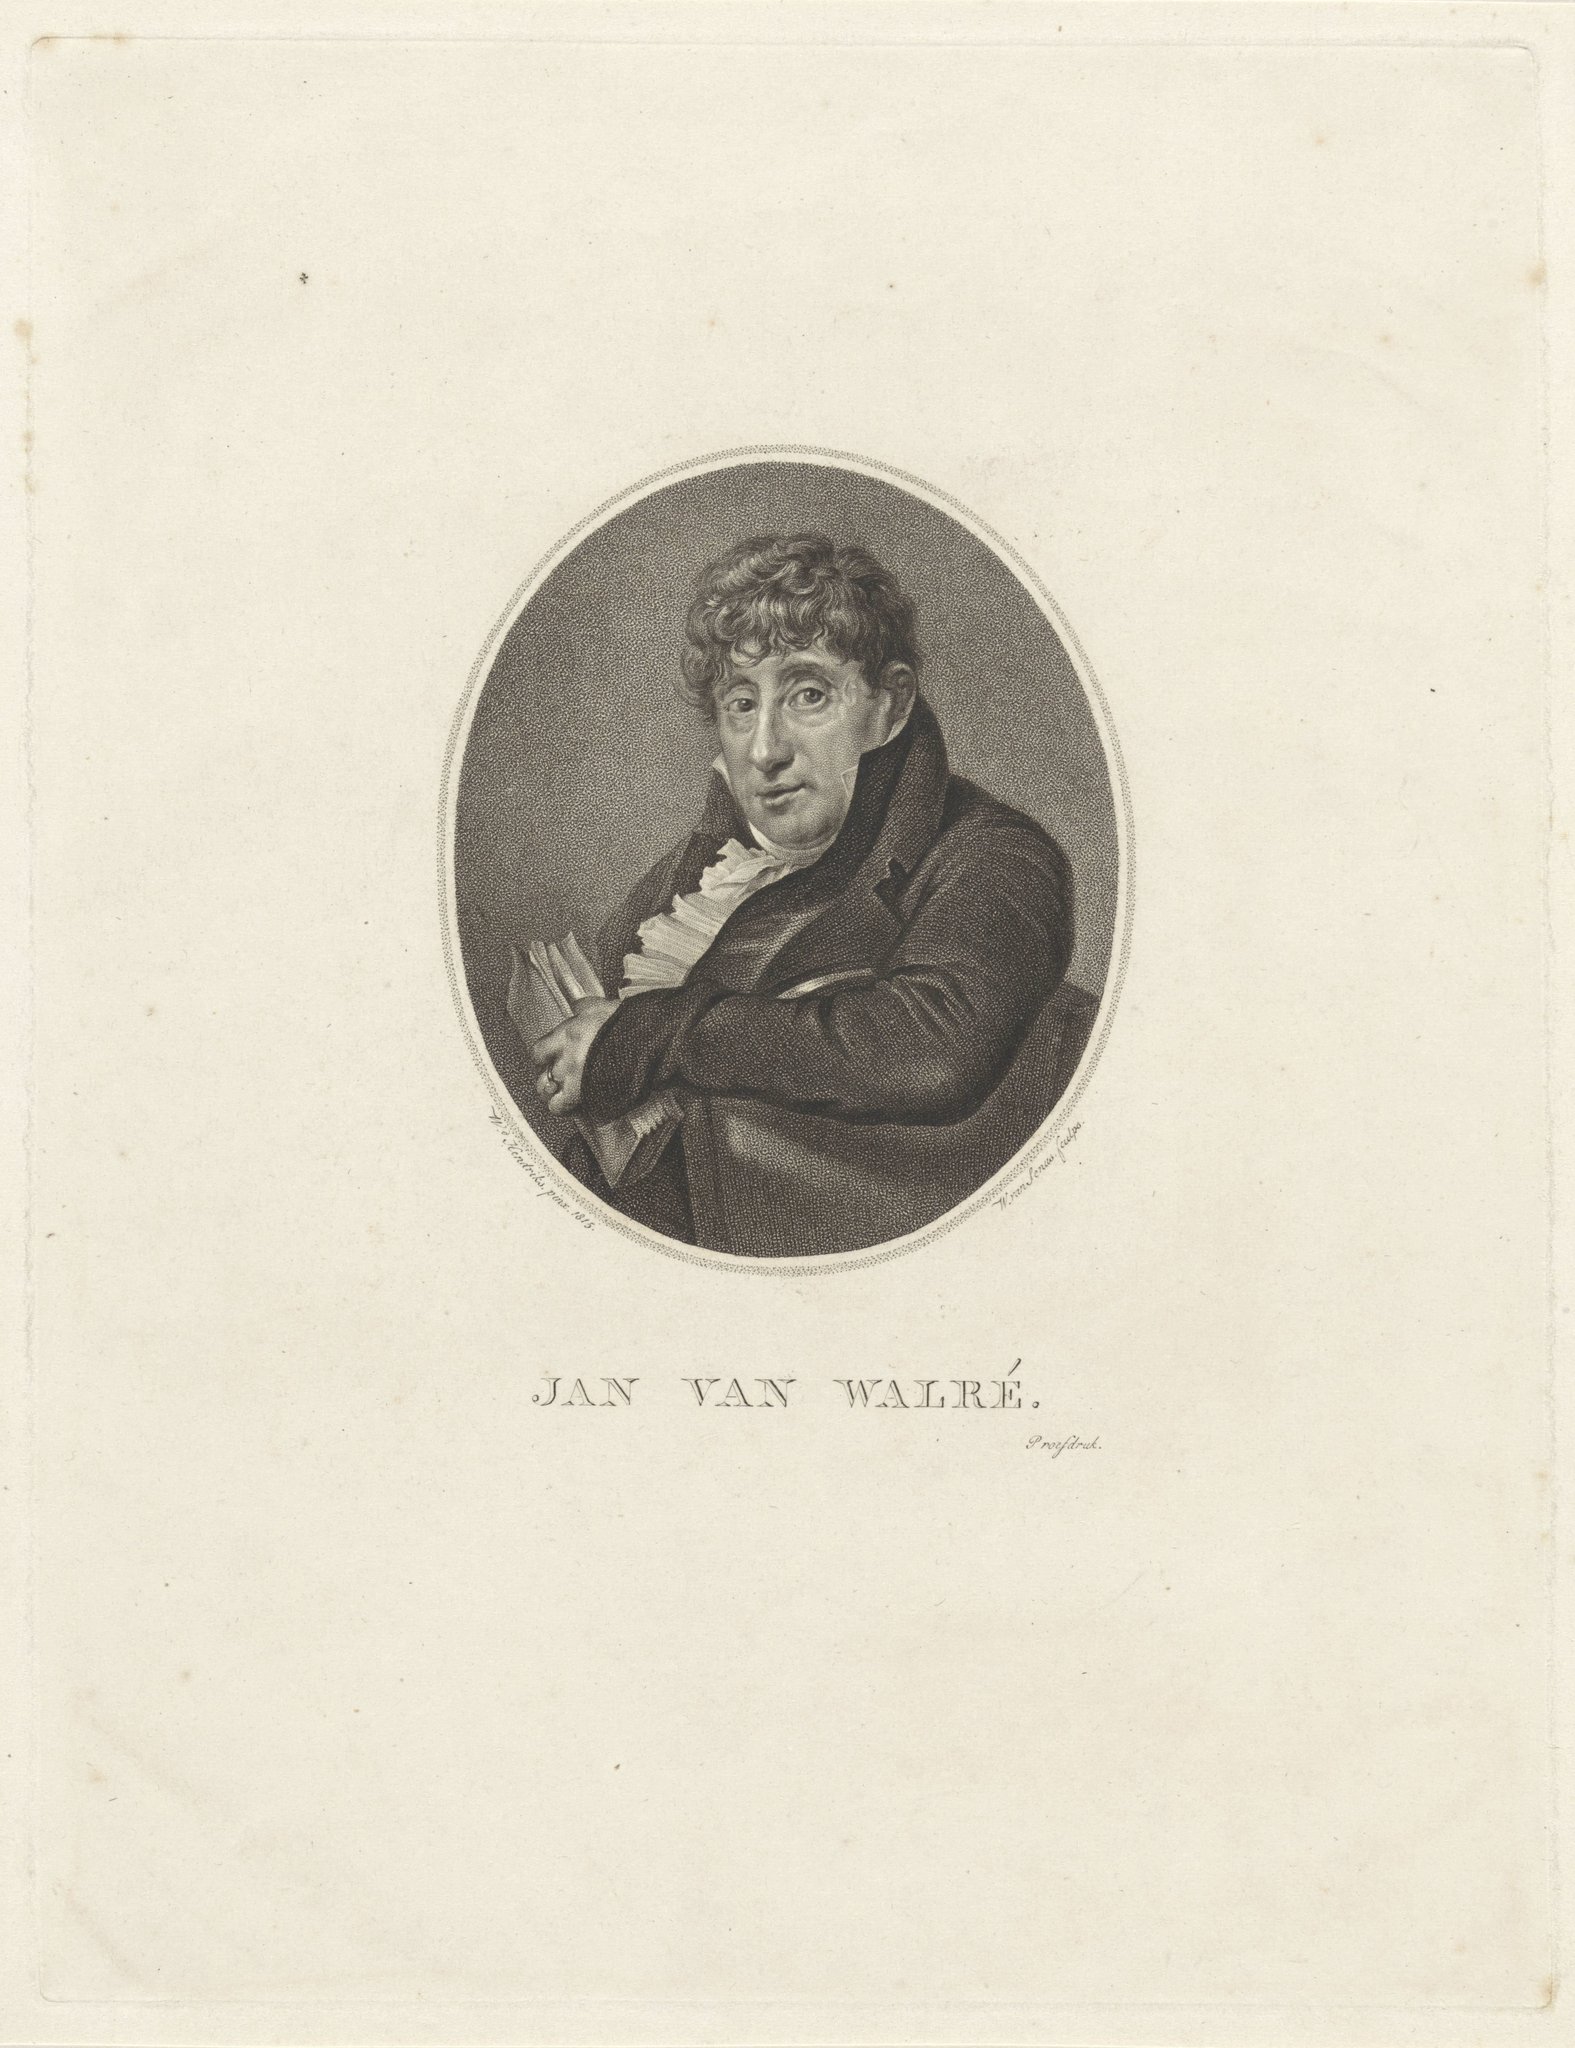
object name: print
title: Portret van Jan van Walré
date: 1815-1851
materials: paper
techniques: engraving, etching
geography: netherlands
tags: haarlem, publisher, jan van walré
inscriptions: collector's mark: Lugt 2228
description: Portret van de Haarlemse schrijver en uitgever Jan van Walré.